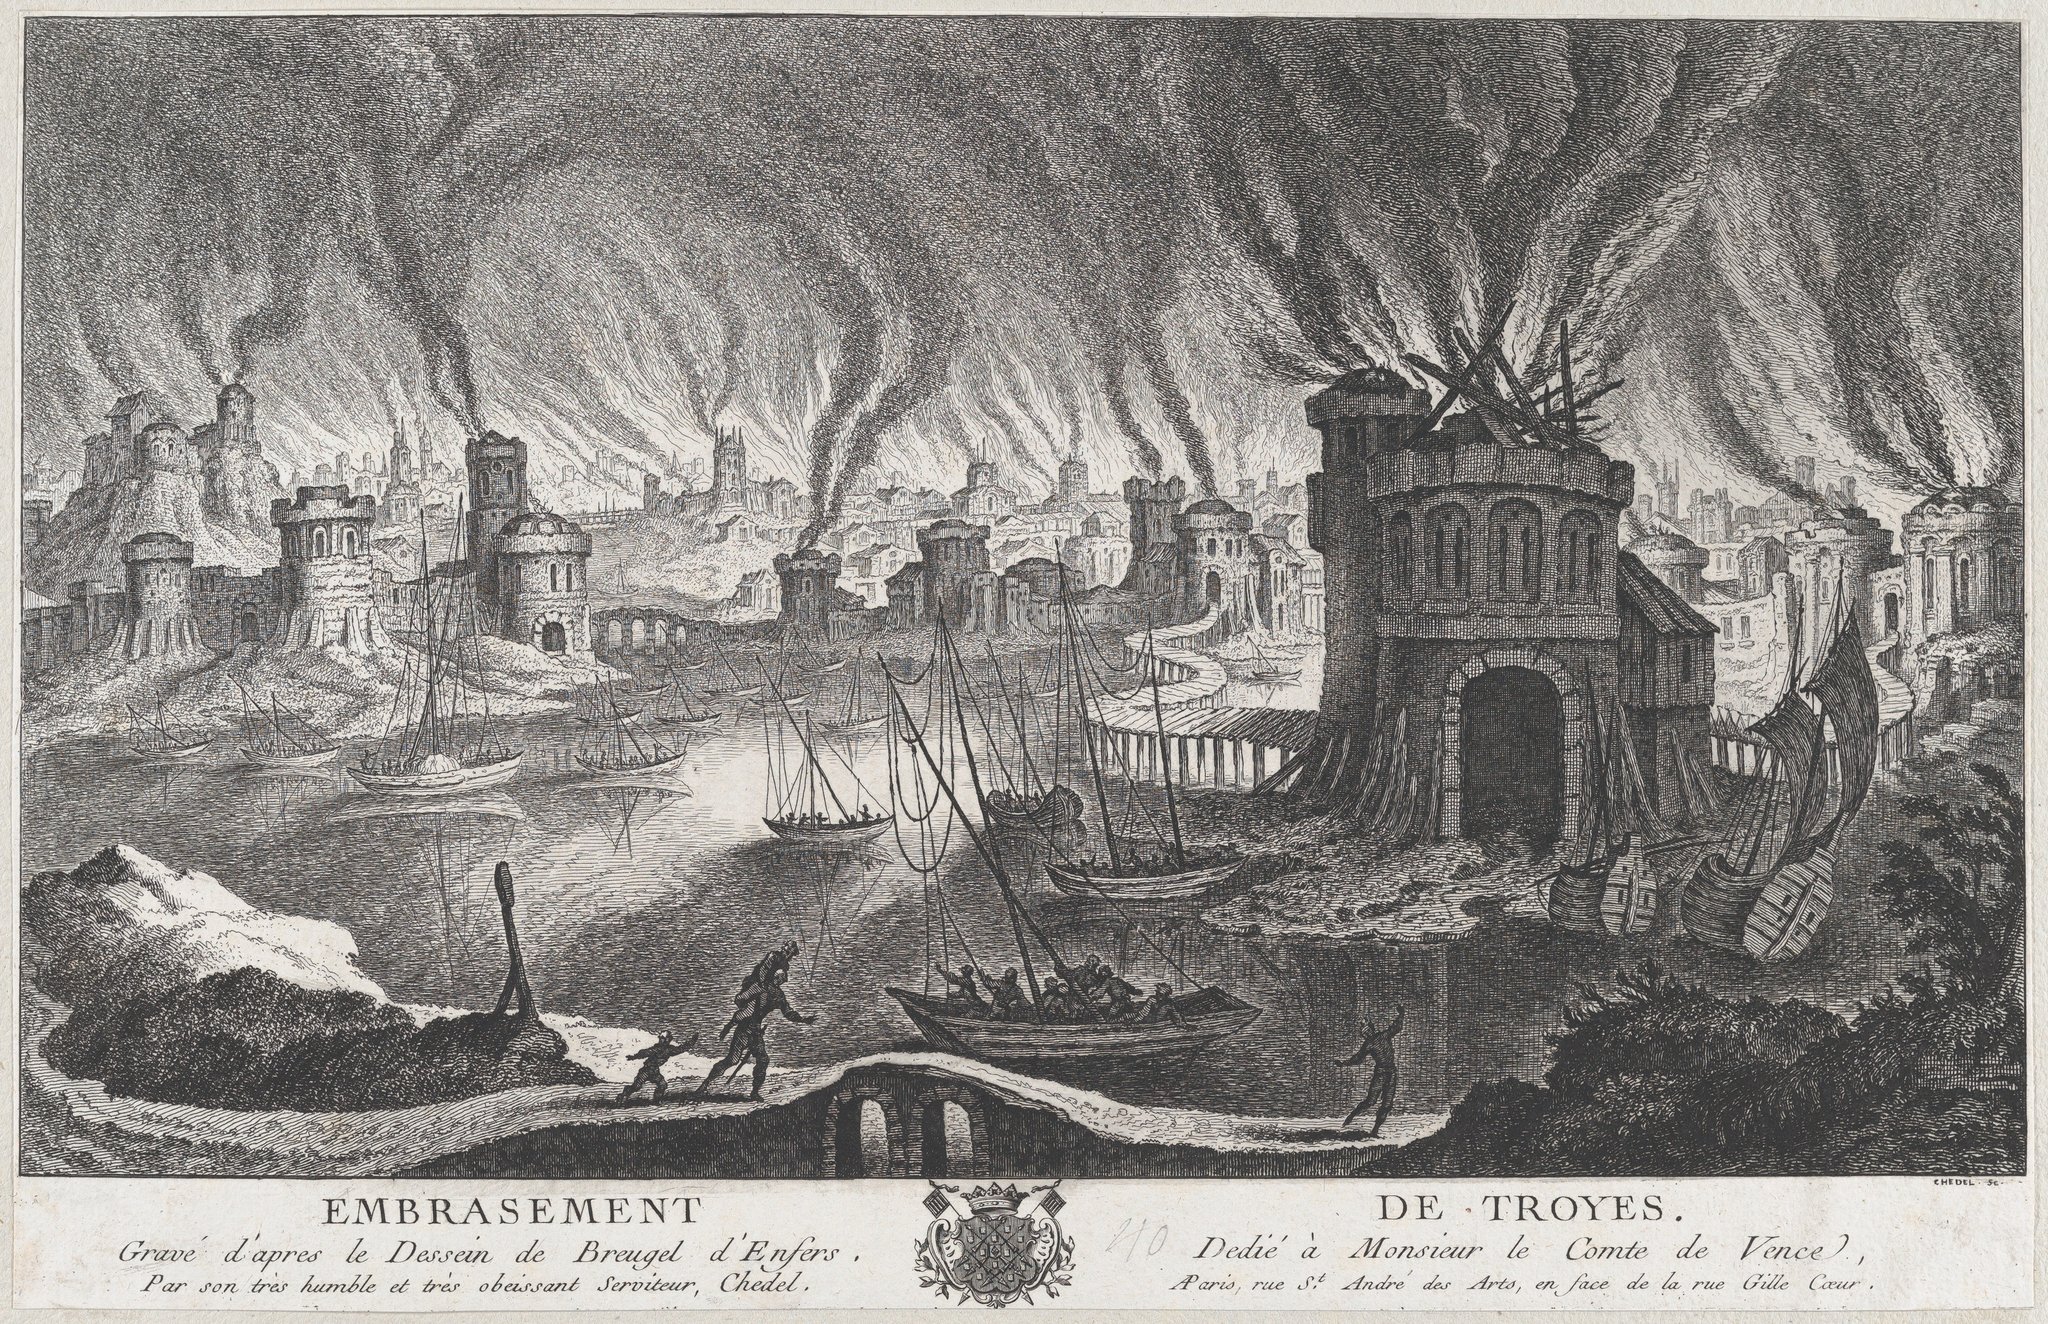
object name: print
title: Embrasement de Troyes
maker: quentin pierre chedel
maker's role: artist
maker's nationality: french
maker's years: 1705-1763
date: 1701-1800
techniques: etching